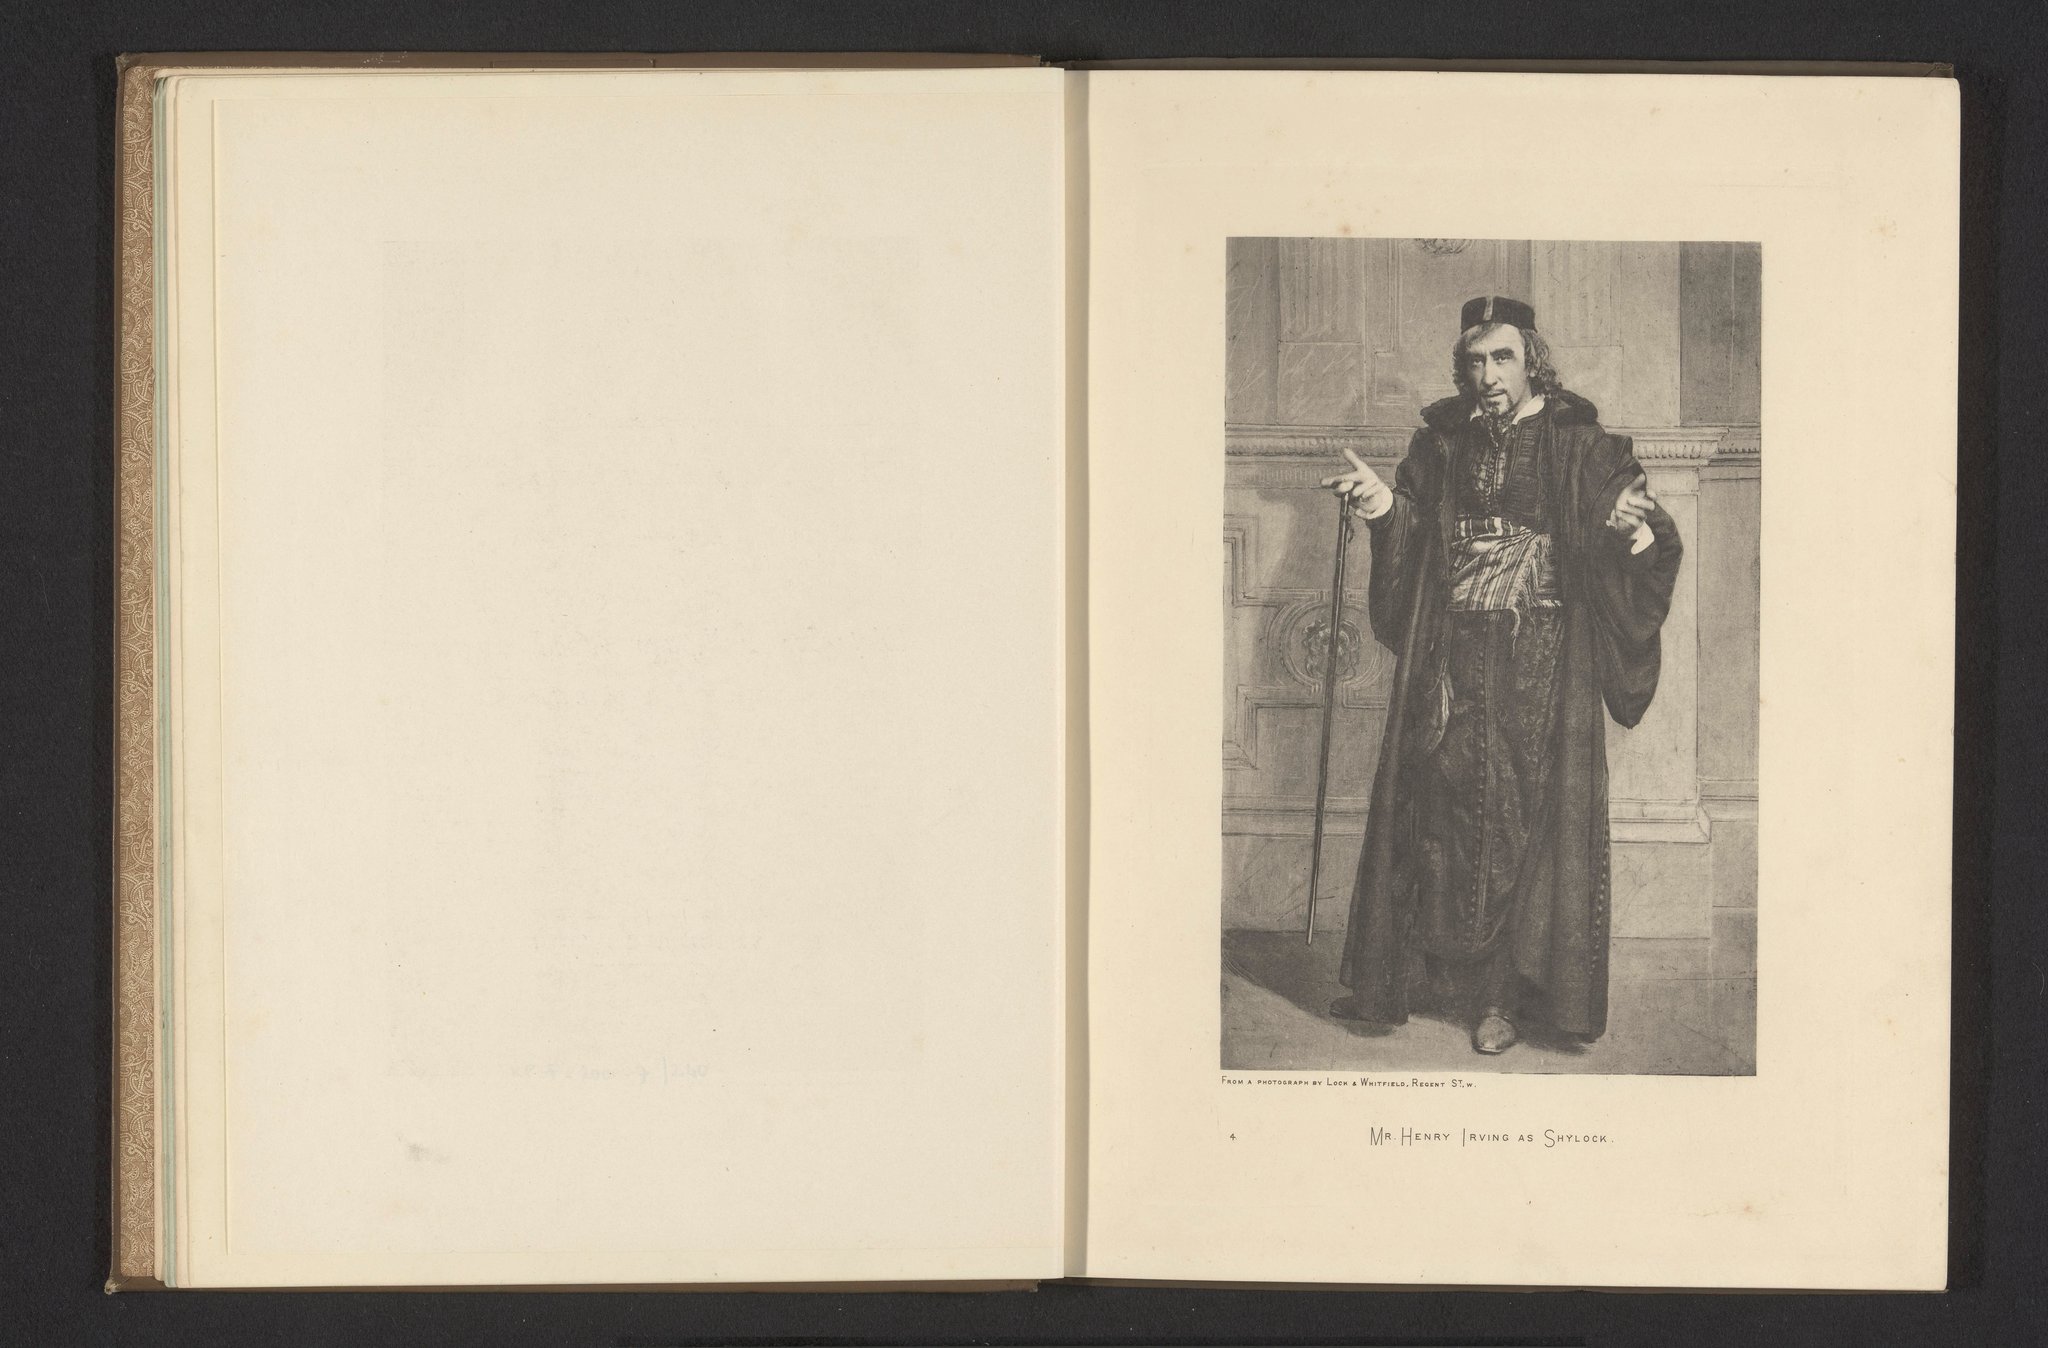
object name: page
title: Mr. Henry Irving as Shylock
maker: Anonymous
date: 1883-1893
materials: paper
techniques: photoaquatint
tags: portrait of actor, actress